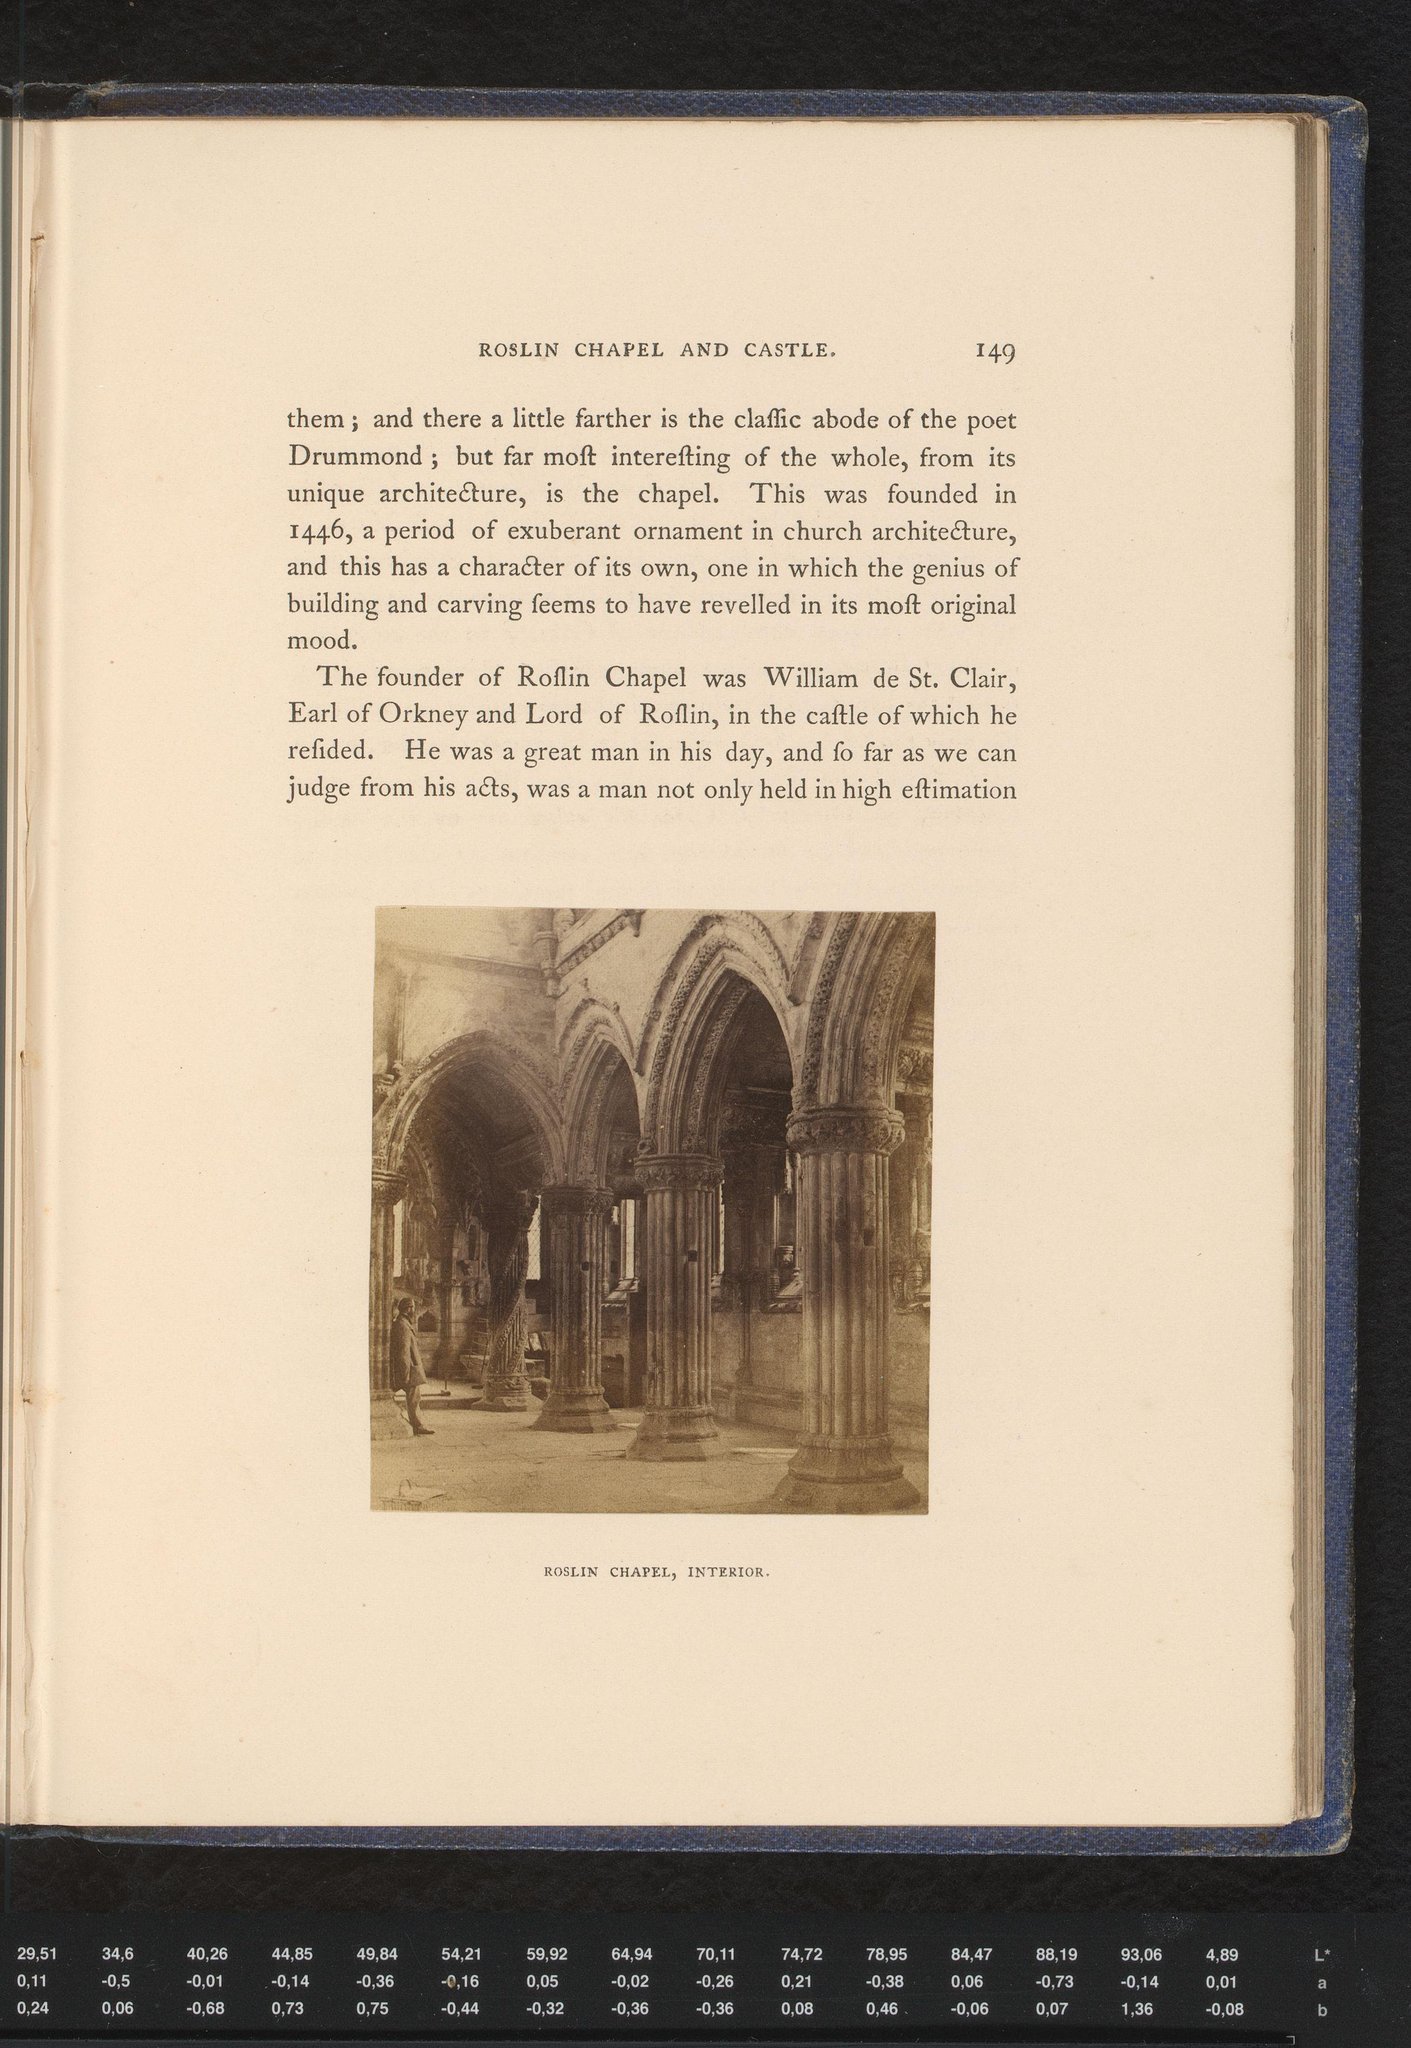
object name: page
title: Roslin Chapel, interior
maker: george washington wilson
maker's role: publisher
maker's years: 1823-1893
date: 1857-1862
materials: paper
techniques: albumen print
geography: rosslyn chapel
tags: parts of church interior: chapel